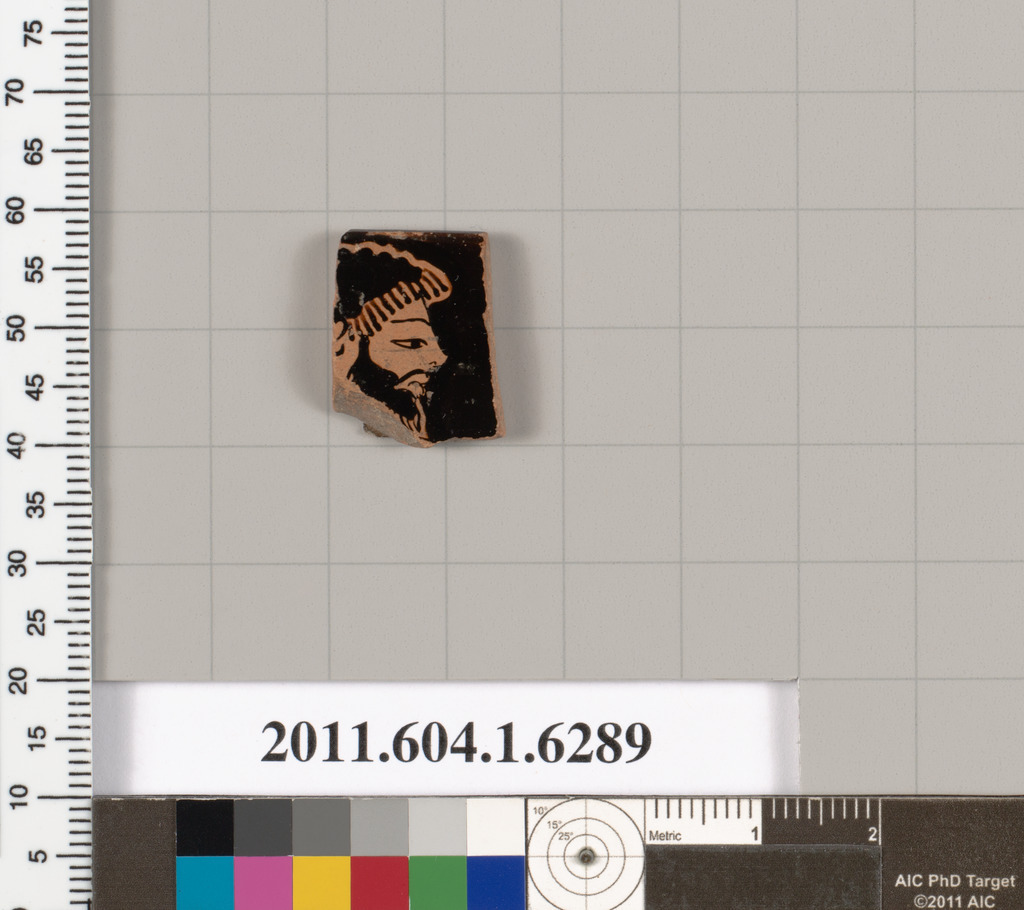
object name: kylix fragment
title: Terracotta rim fragment of a kylix (drinking cup)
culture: greek, attic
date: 500-480 BCE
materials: terracotta